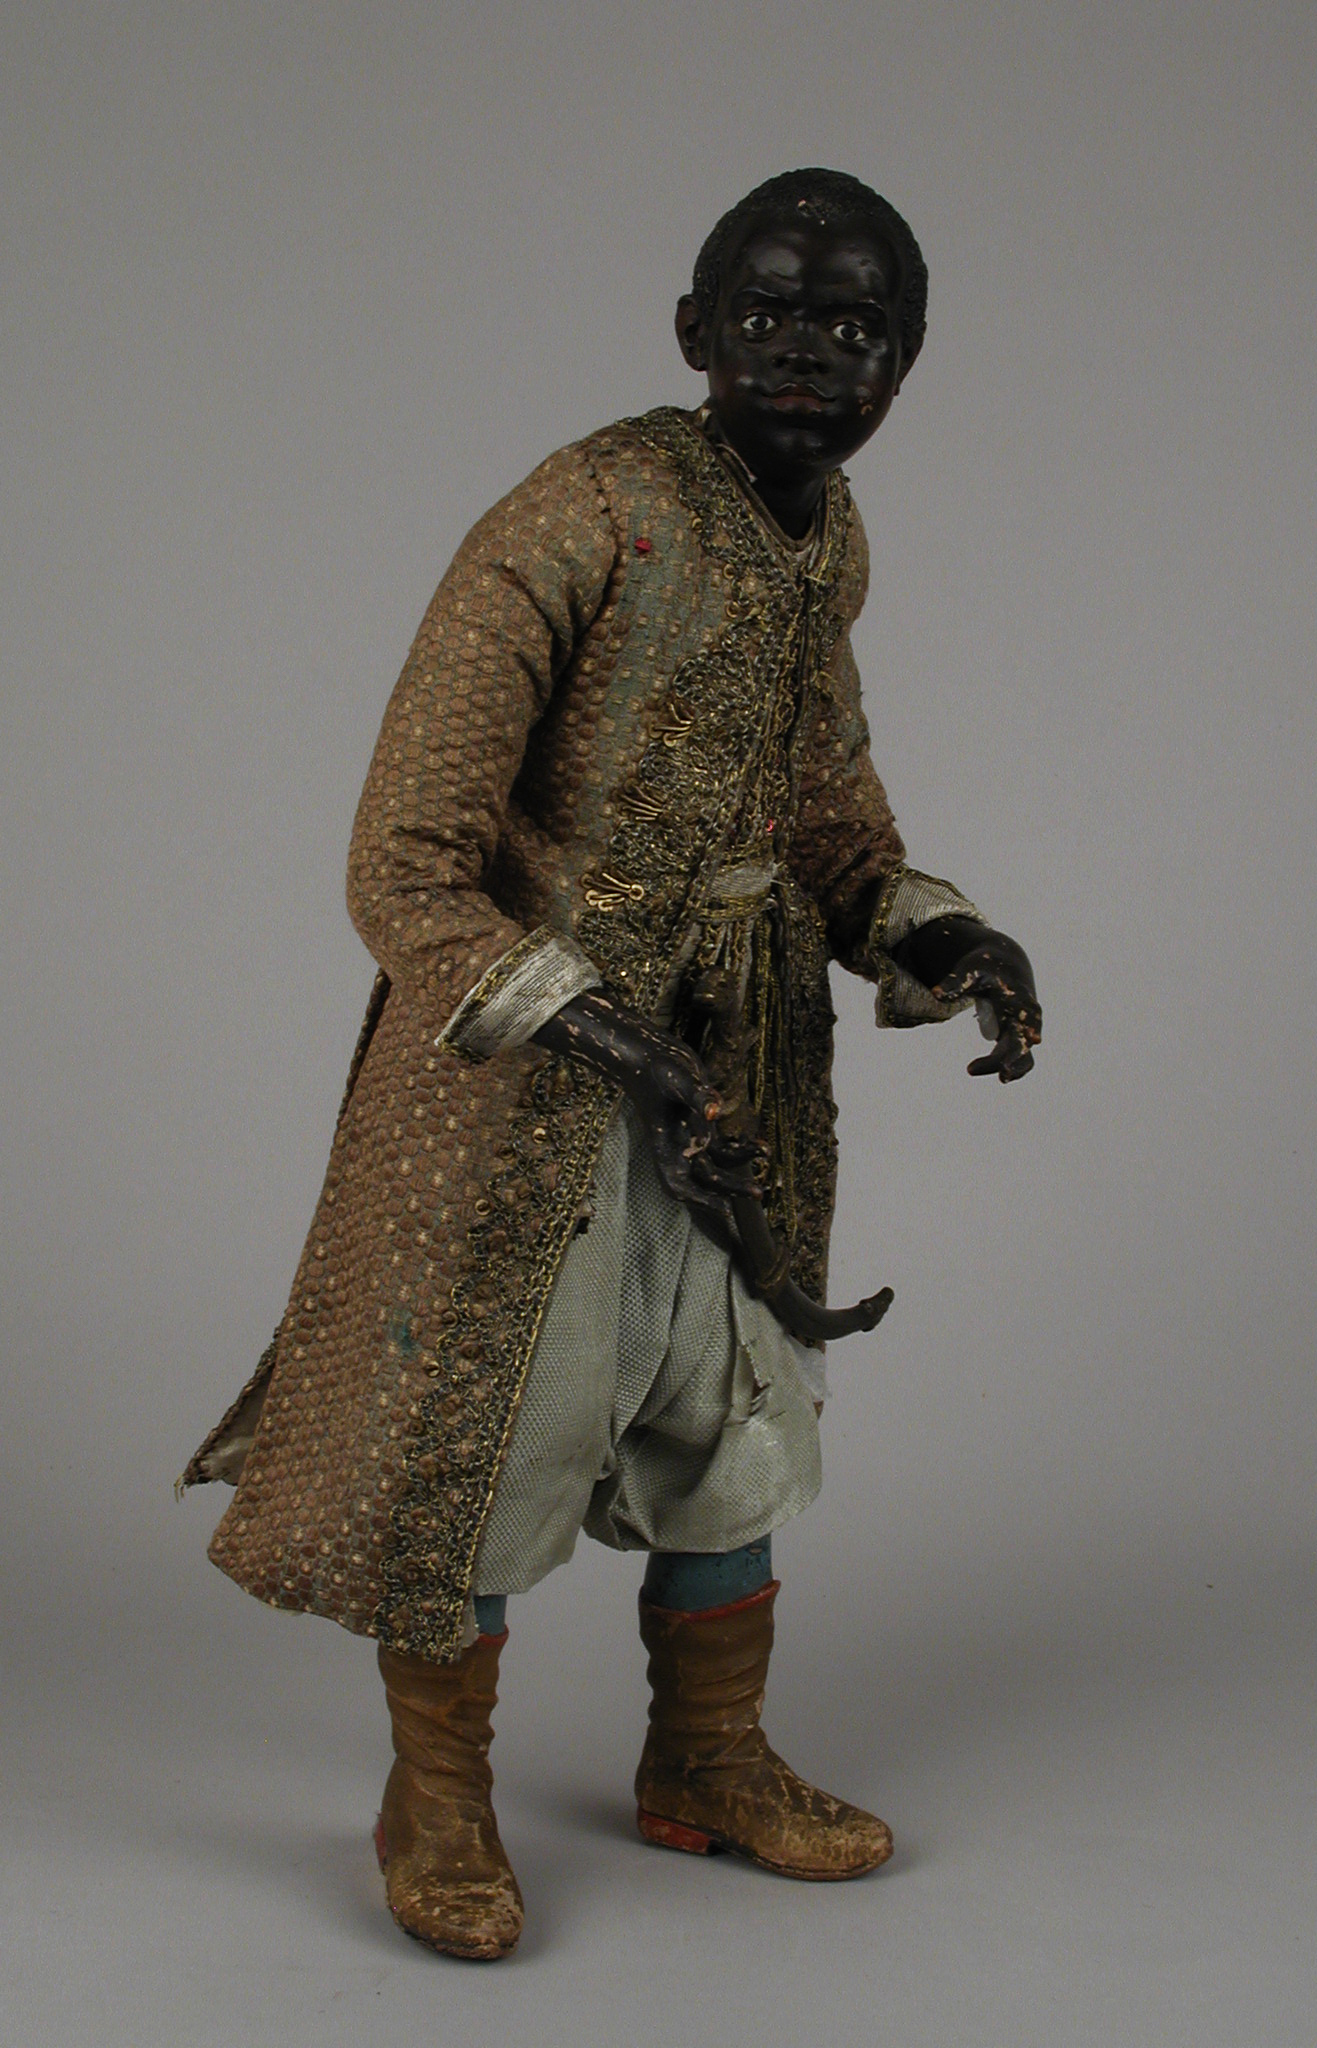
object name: crèche figure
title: King's Moorish attendant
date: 1751-1800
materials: brass, cotton, gold, metal thread, silk, silver, terracotta, fiber, metal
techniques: polychrome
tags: men